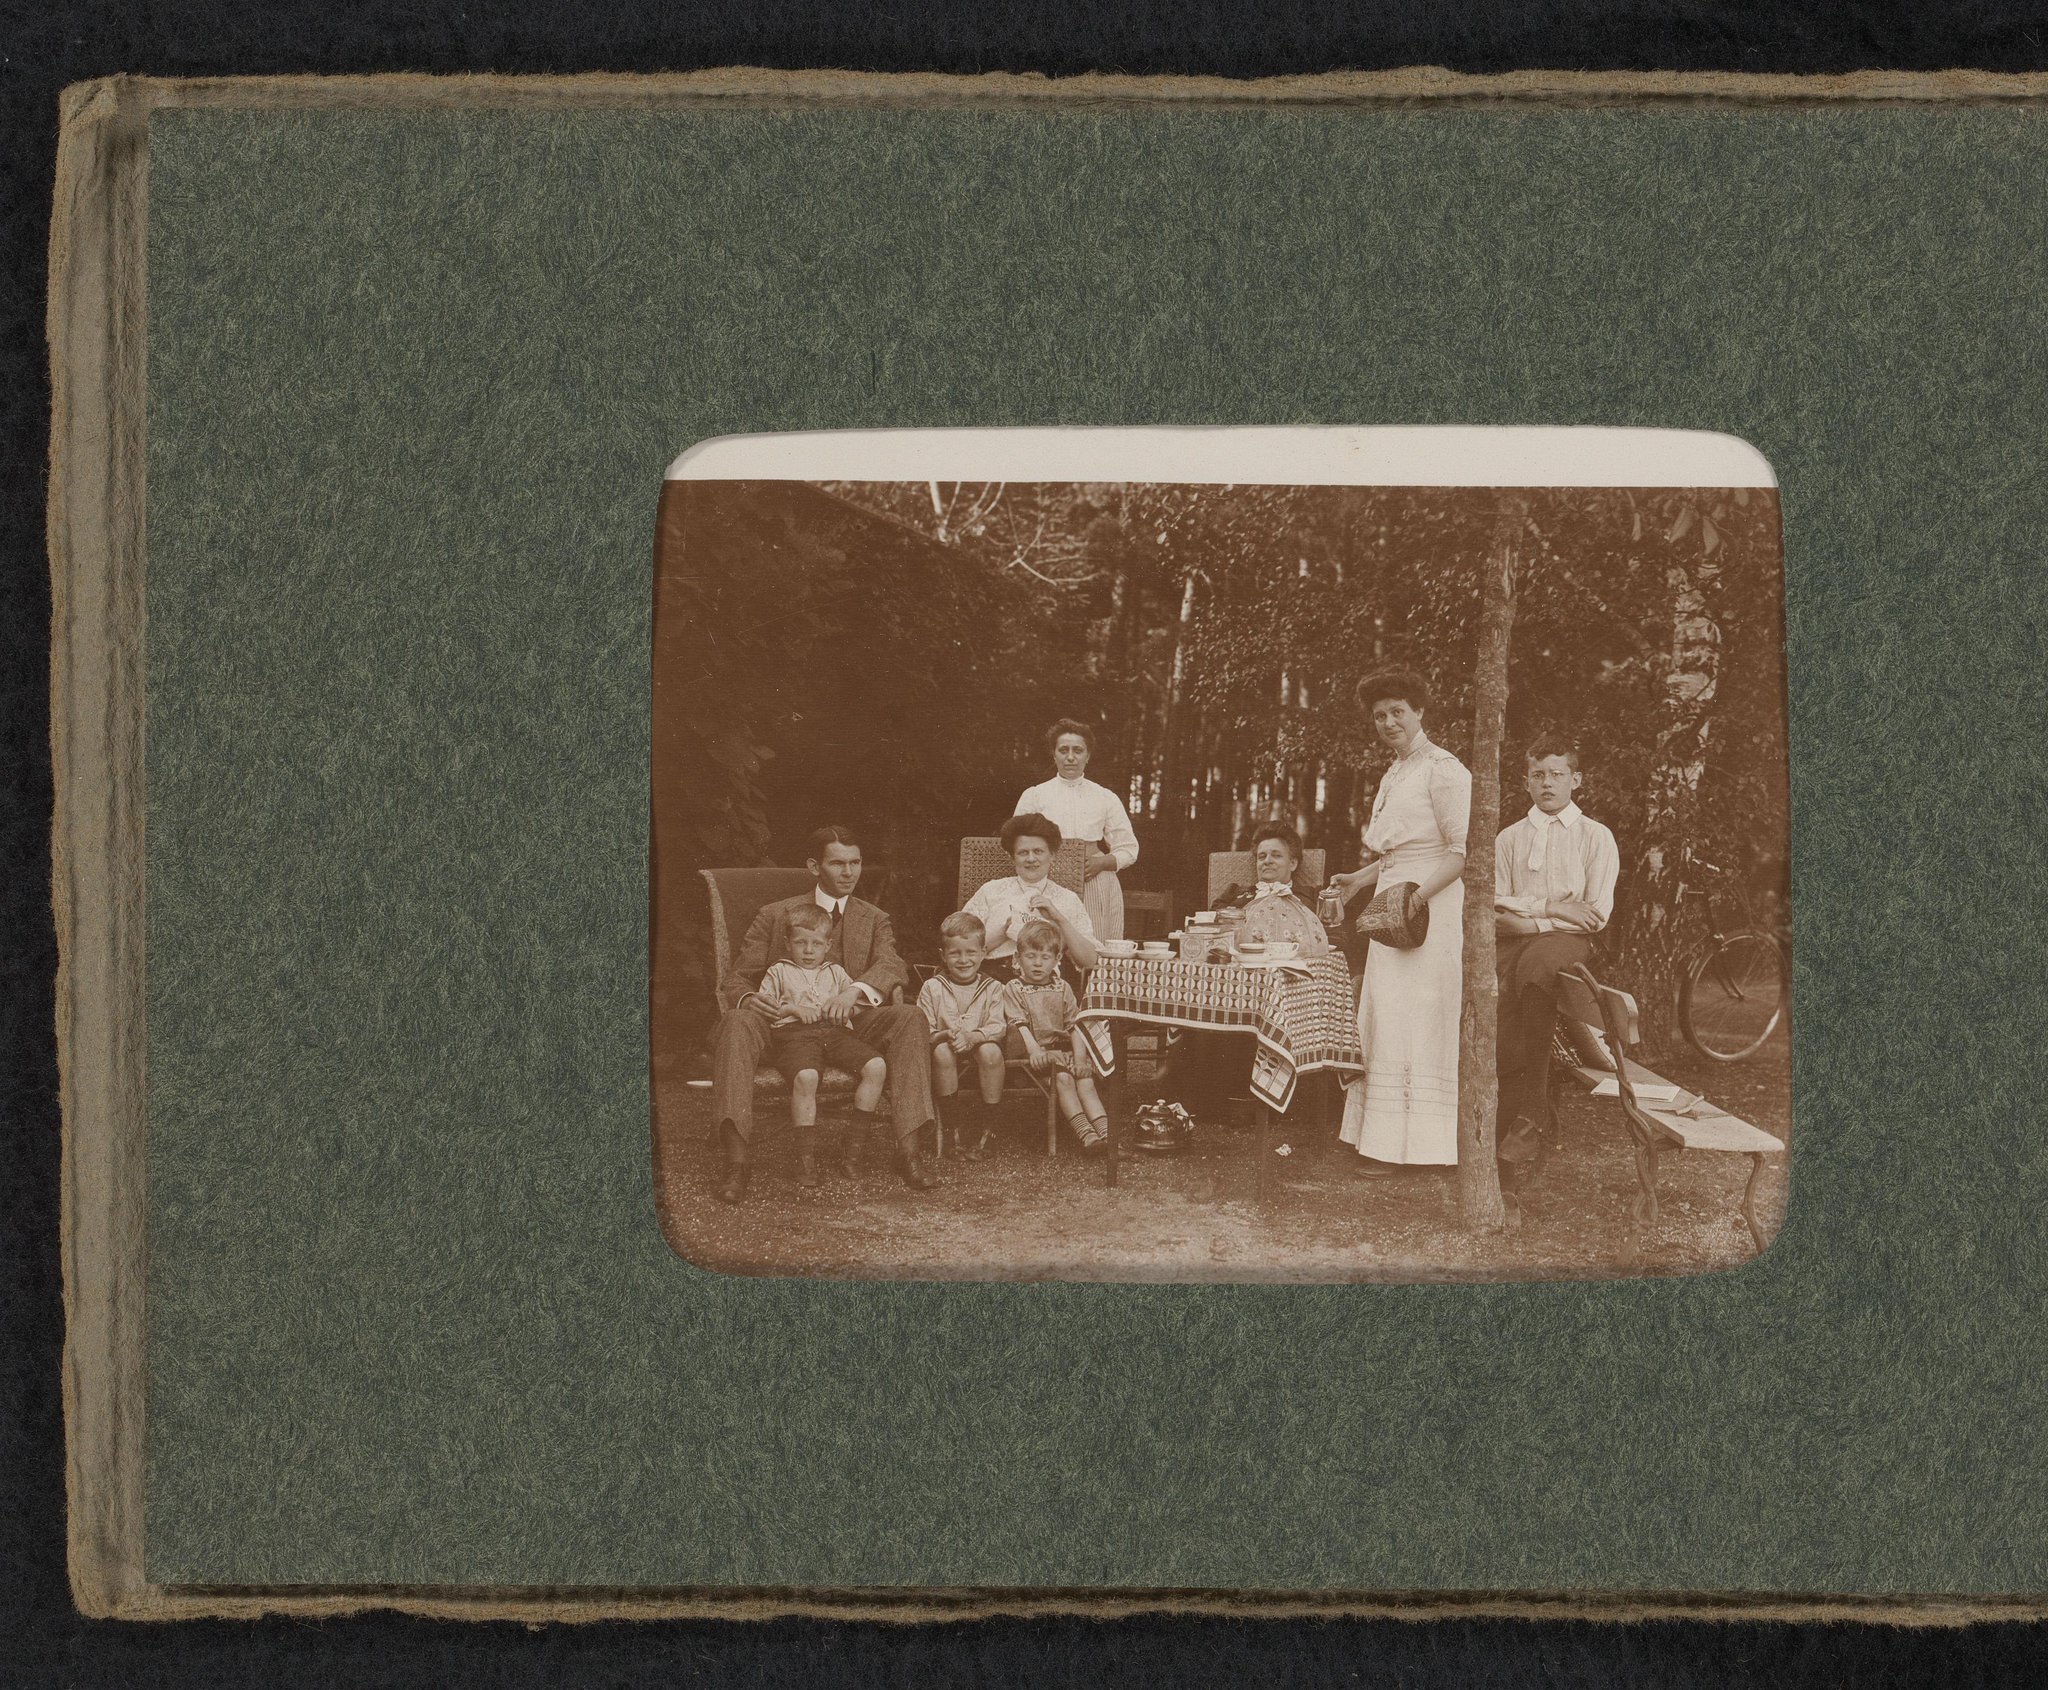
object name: photograph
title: Familie van den Berg bij een vakantiehuis in Huis ter Heide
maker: hendrik herman van den berg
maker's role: amateurfotograaf, jurist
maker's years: 1875-1944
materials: paper, cardboard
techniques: gelatin silver print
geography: huis ter heide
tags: amsterdam, norbert van den berg (1901-1972), the hague, caroline louise van den berg-van den berg, family life